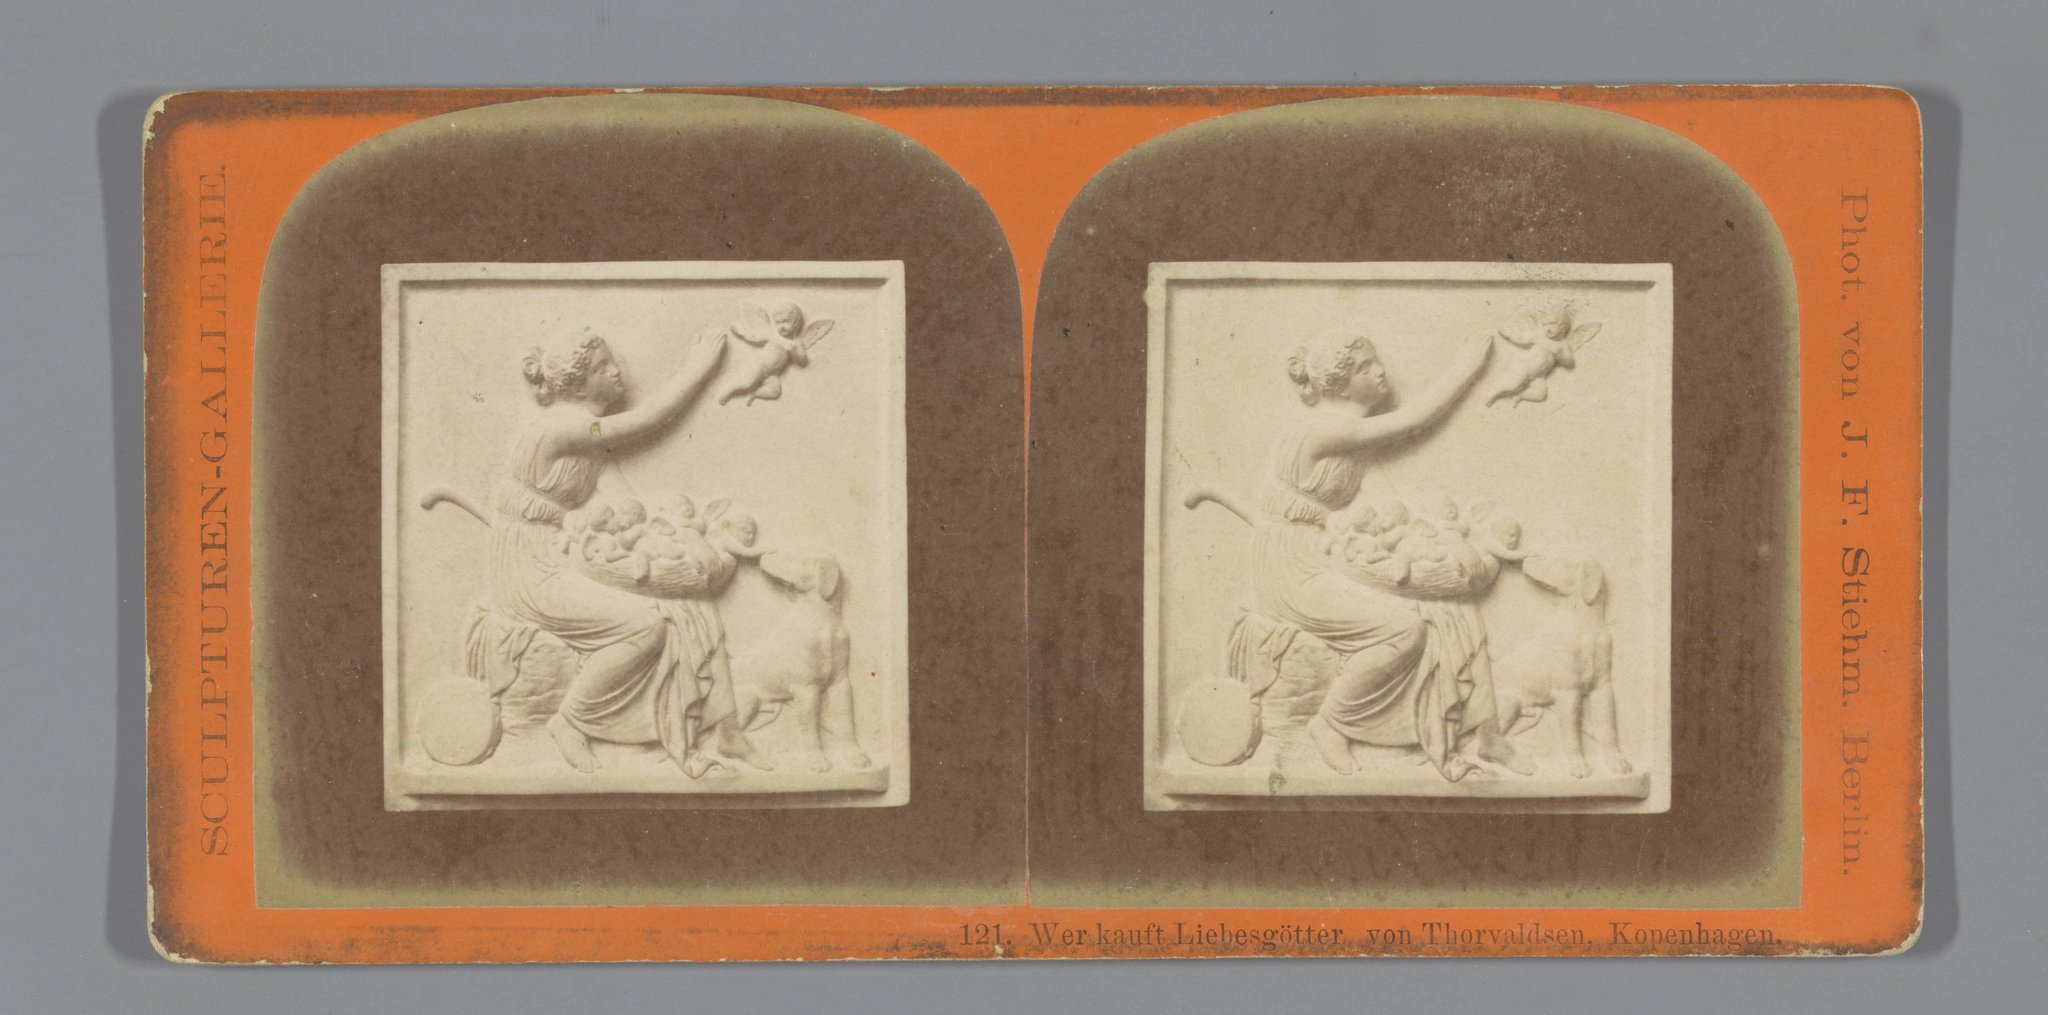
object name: stereograph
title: Plaquette van een vrouw met een mand vol Amors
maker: johann friedrich stiehm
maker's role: fotograaf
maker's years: 1826-1902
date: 1855-1890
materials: cardboard, photographic support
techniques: albumen print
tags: copenhagen (city), draughtsman, sculptor, bertel thorvaldsen, sculpture, angel(s) represented as child(ren)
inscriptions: : ‘Berlin’, number: ‘121’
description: Sculptuur van de Deens-IJslandse beeldhouwer Bertel Thorvaldsen.